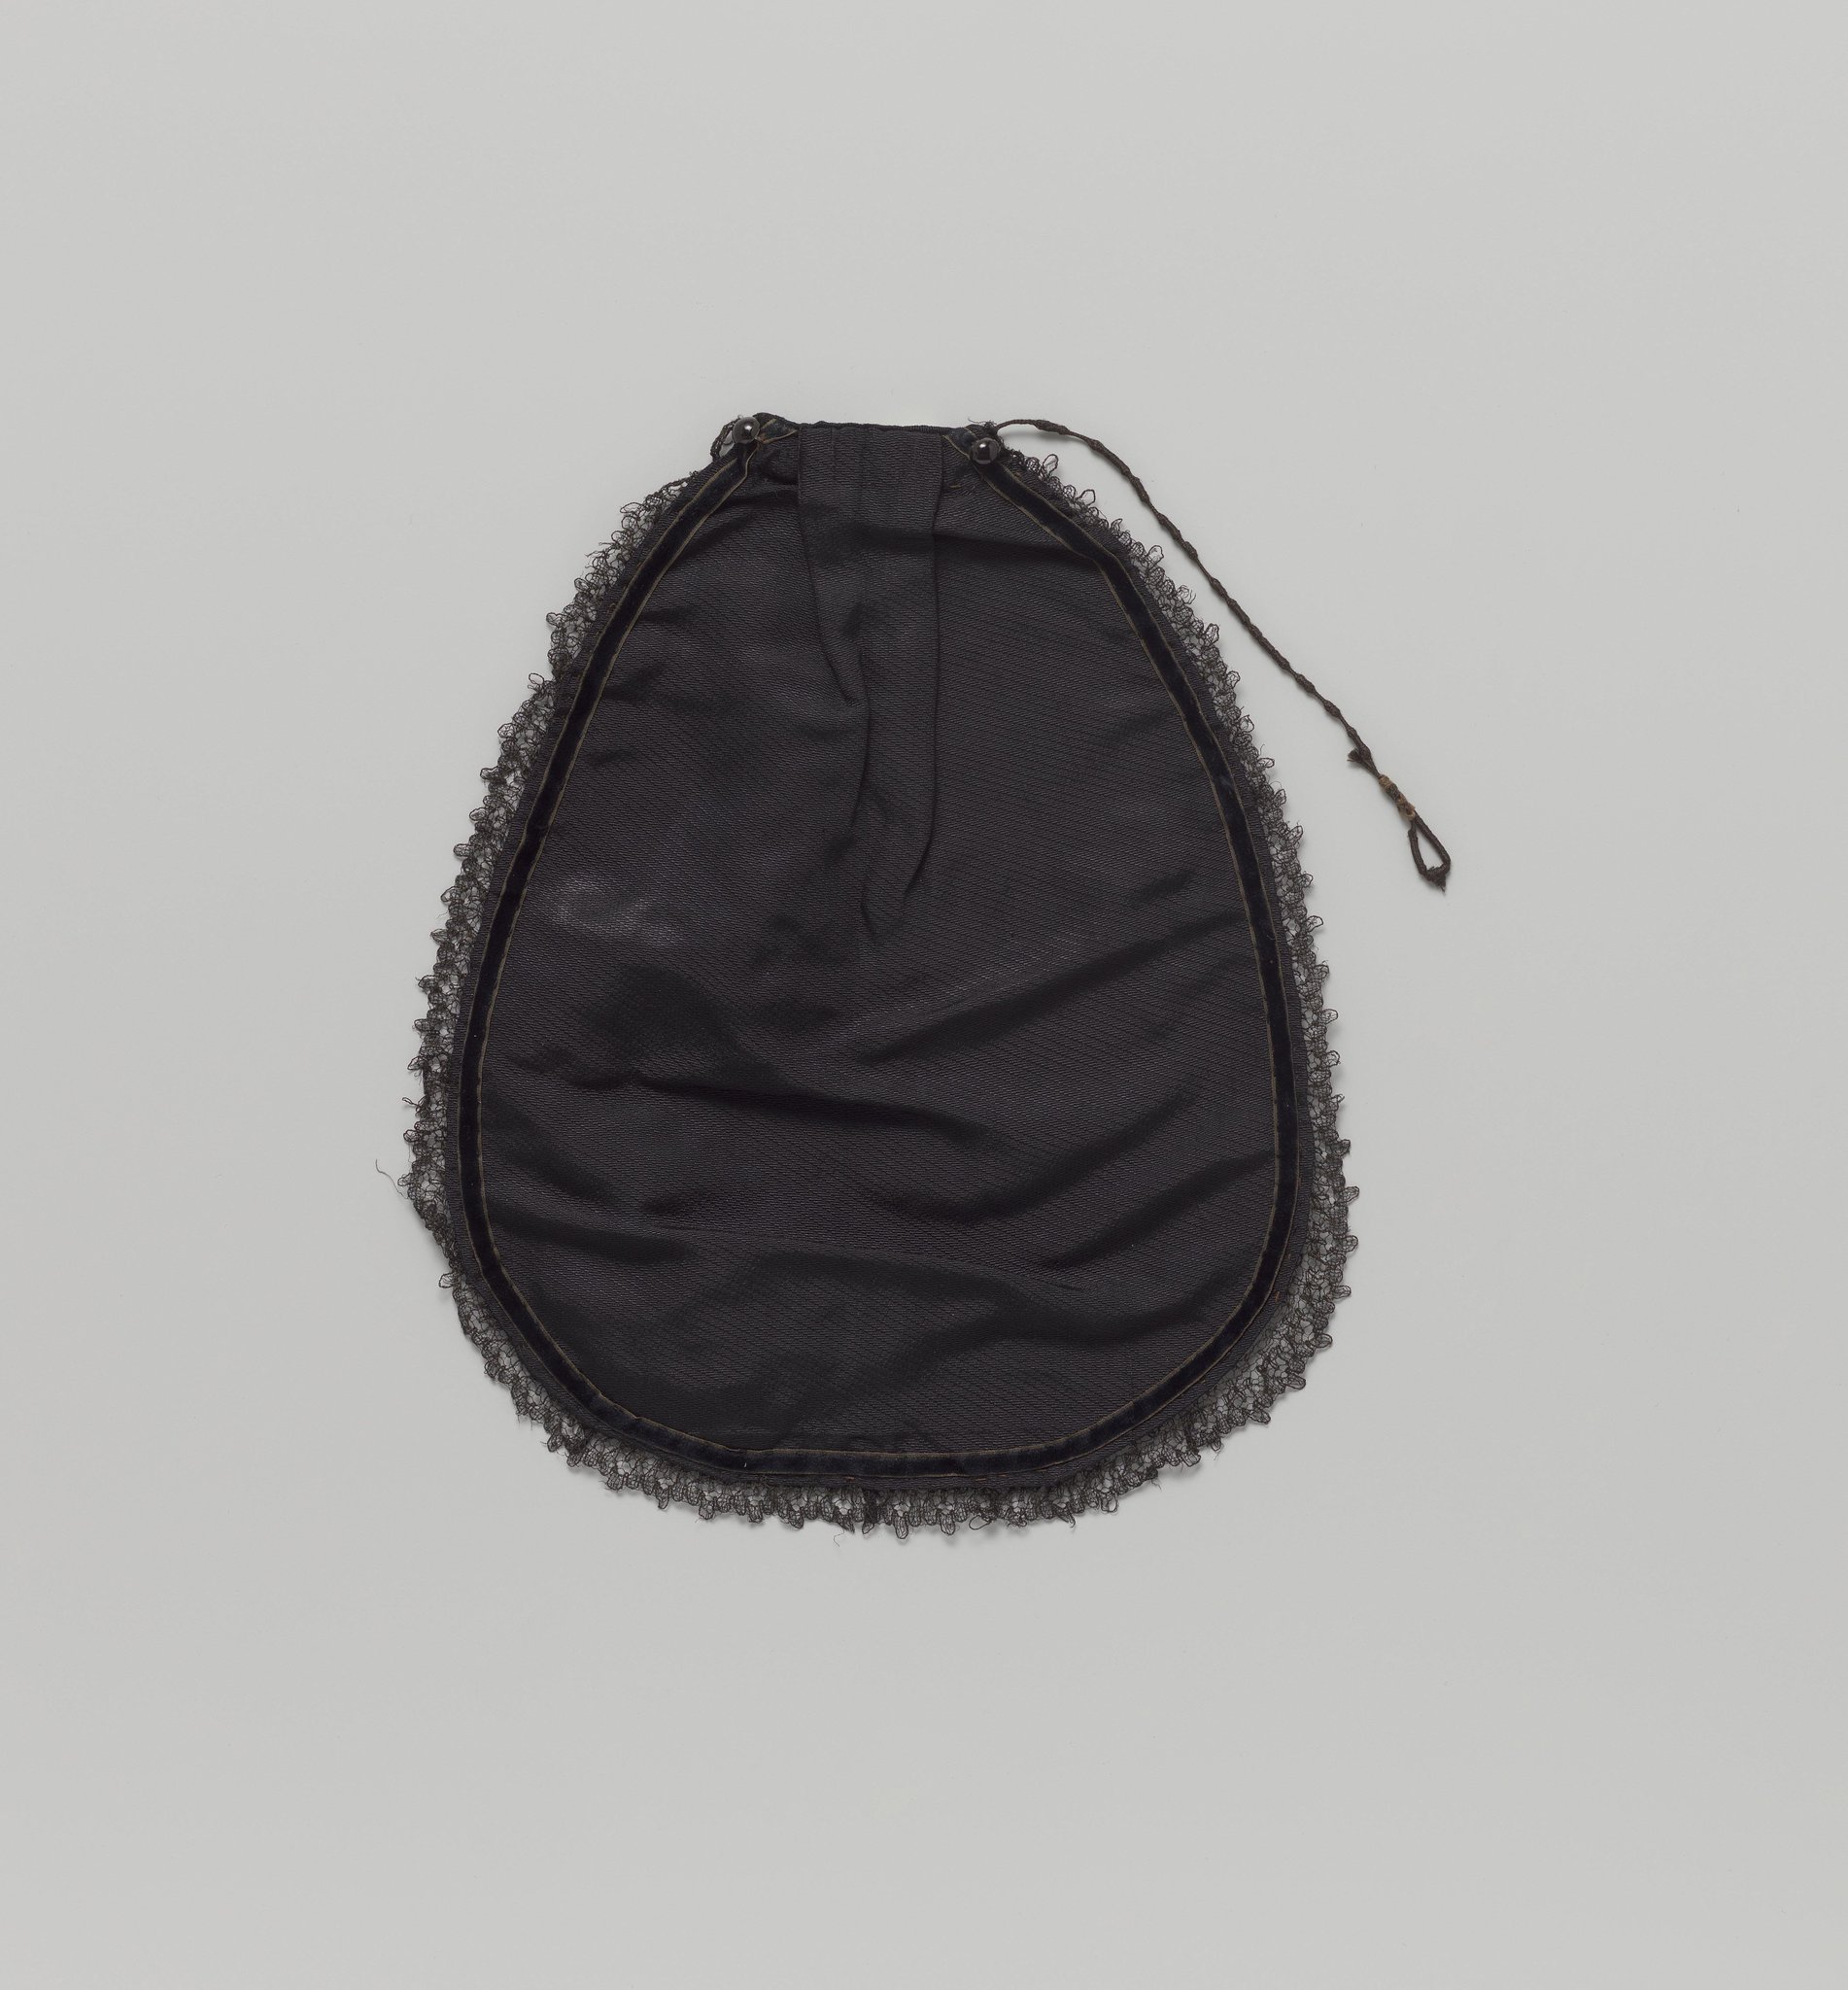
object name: apron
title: Zwart schort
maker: Anonymous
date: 1850-1920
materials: textile, velvet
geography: netherlands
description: Het schort heeft links- en rechtsboven een glanzende bolle zwarte knoop en is langs de randen afgezet met een strook zwarte kant met iets daarboven een band zwart fluweel.